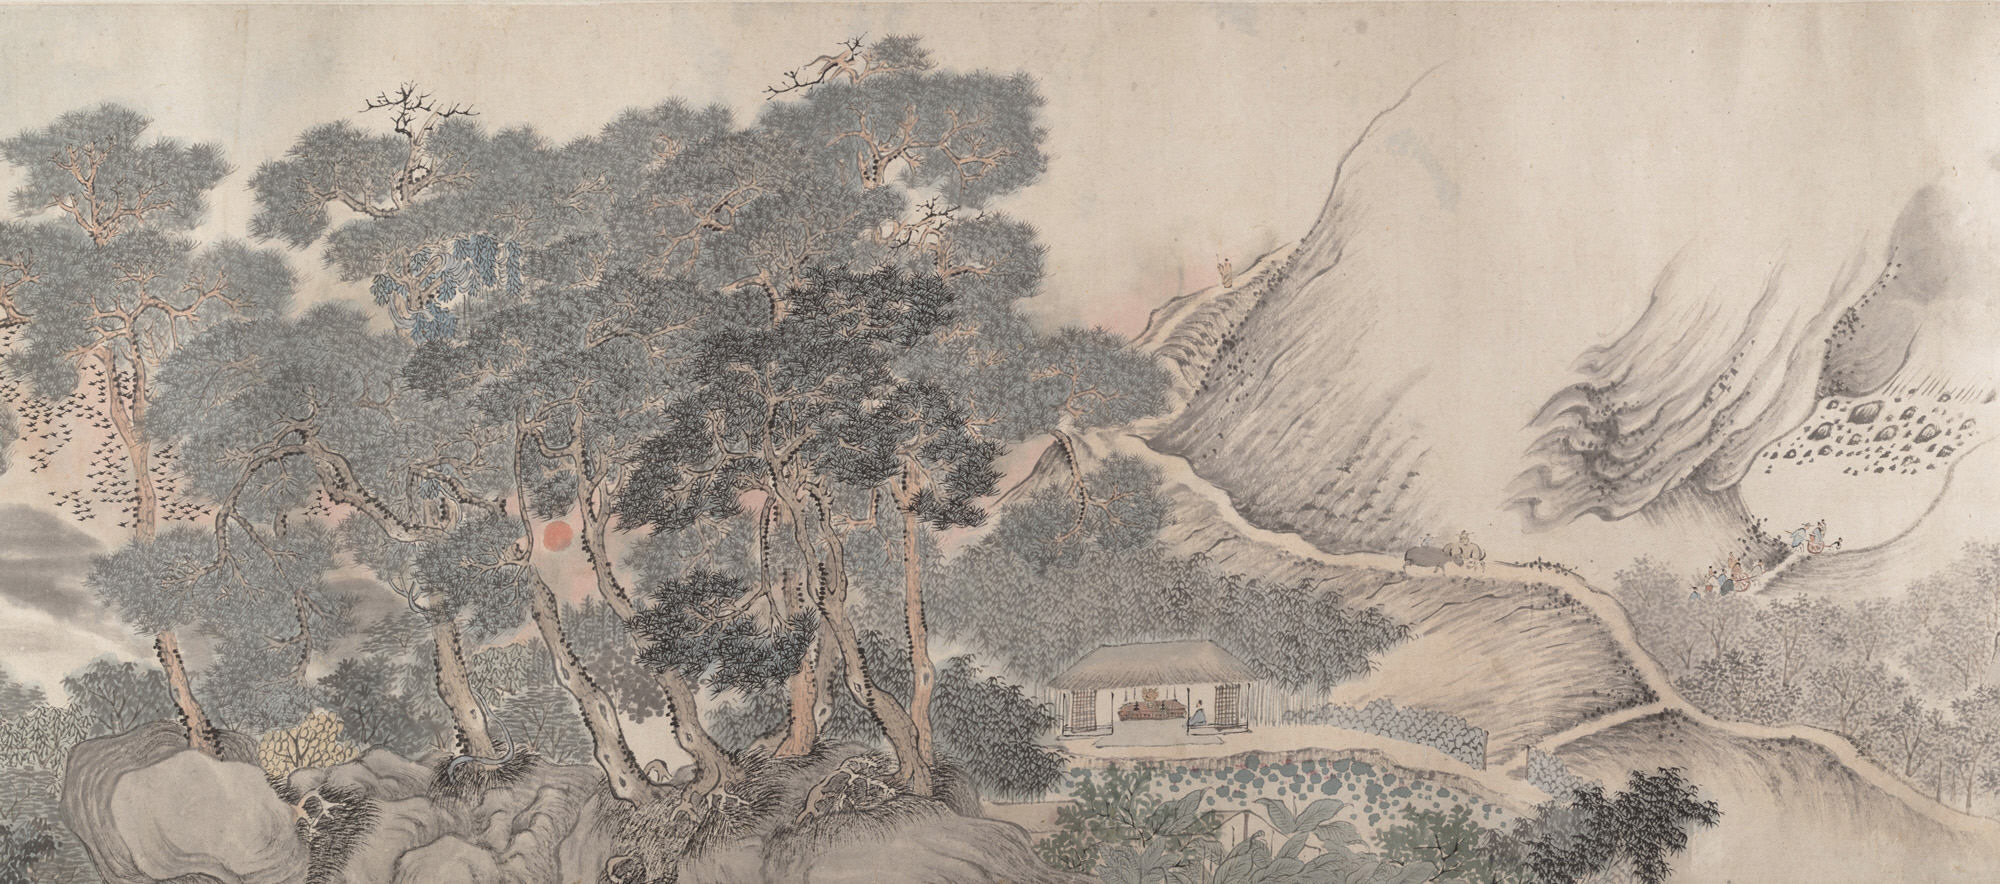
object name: handscroll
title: Landscape of the four seasons in the styles of old masters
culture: chinese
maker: wei zhike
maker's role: artist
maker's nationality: chinese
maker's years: 1600-1636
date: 1635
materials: ink, paper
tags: mountains,landscapes